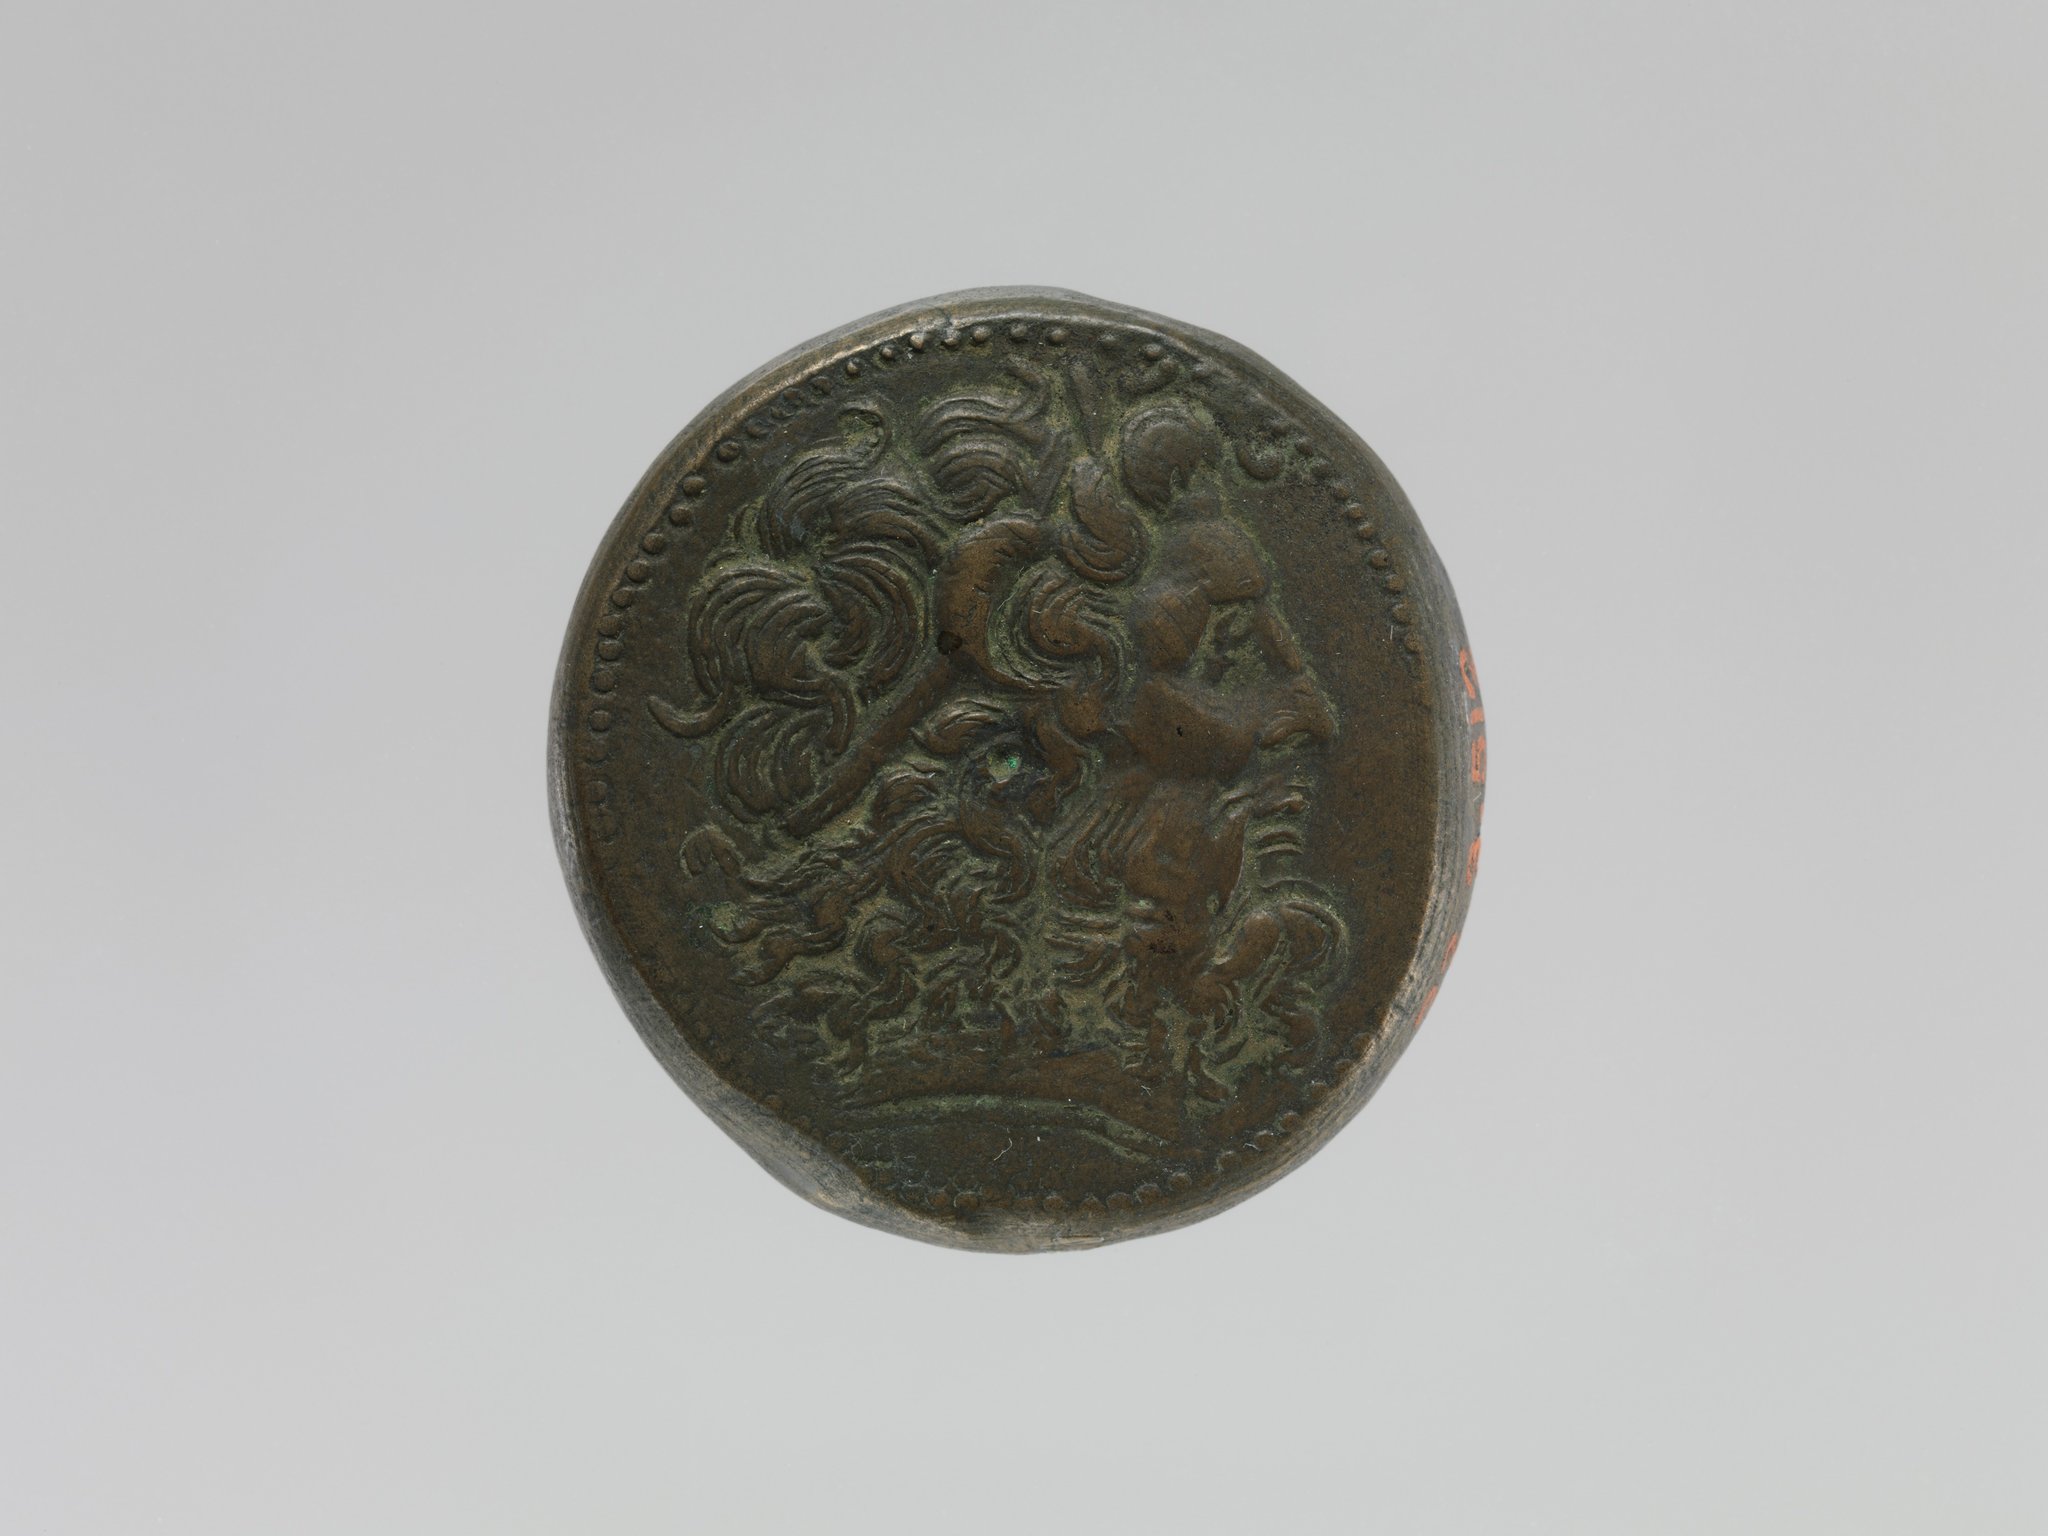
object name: coin, ptolemy ii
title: Coin of Ptolemy II from a Ptolemaic hoard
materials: bronze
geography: egypt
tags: birds,kings